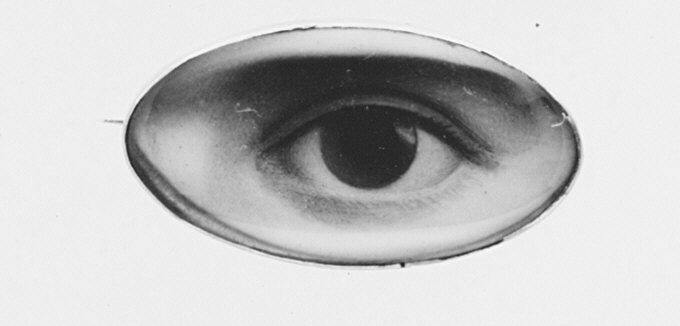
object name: painting, miniature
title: Eye Miniature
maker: british painter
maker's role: artist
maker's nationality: british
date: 1800-1829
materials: ivory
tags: eyes